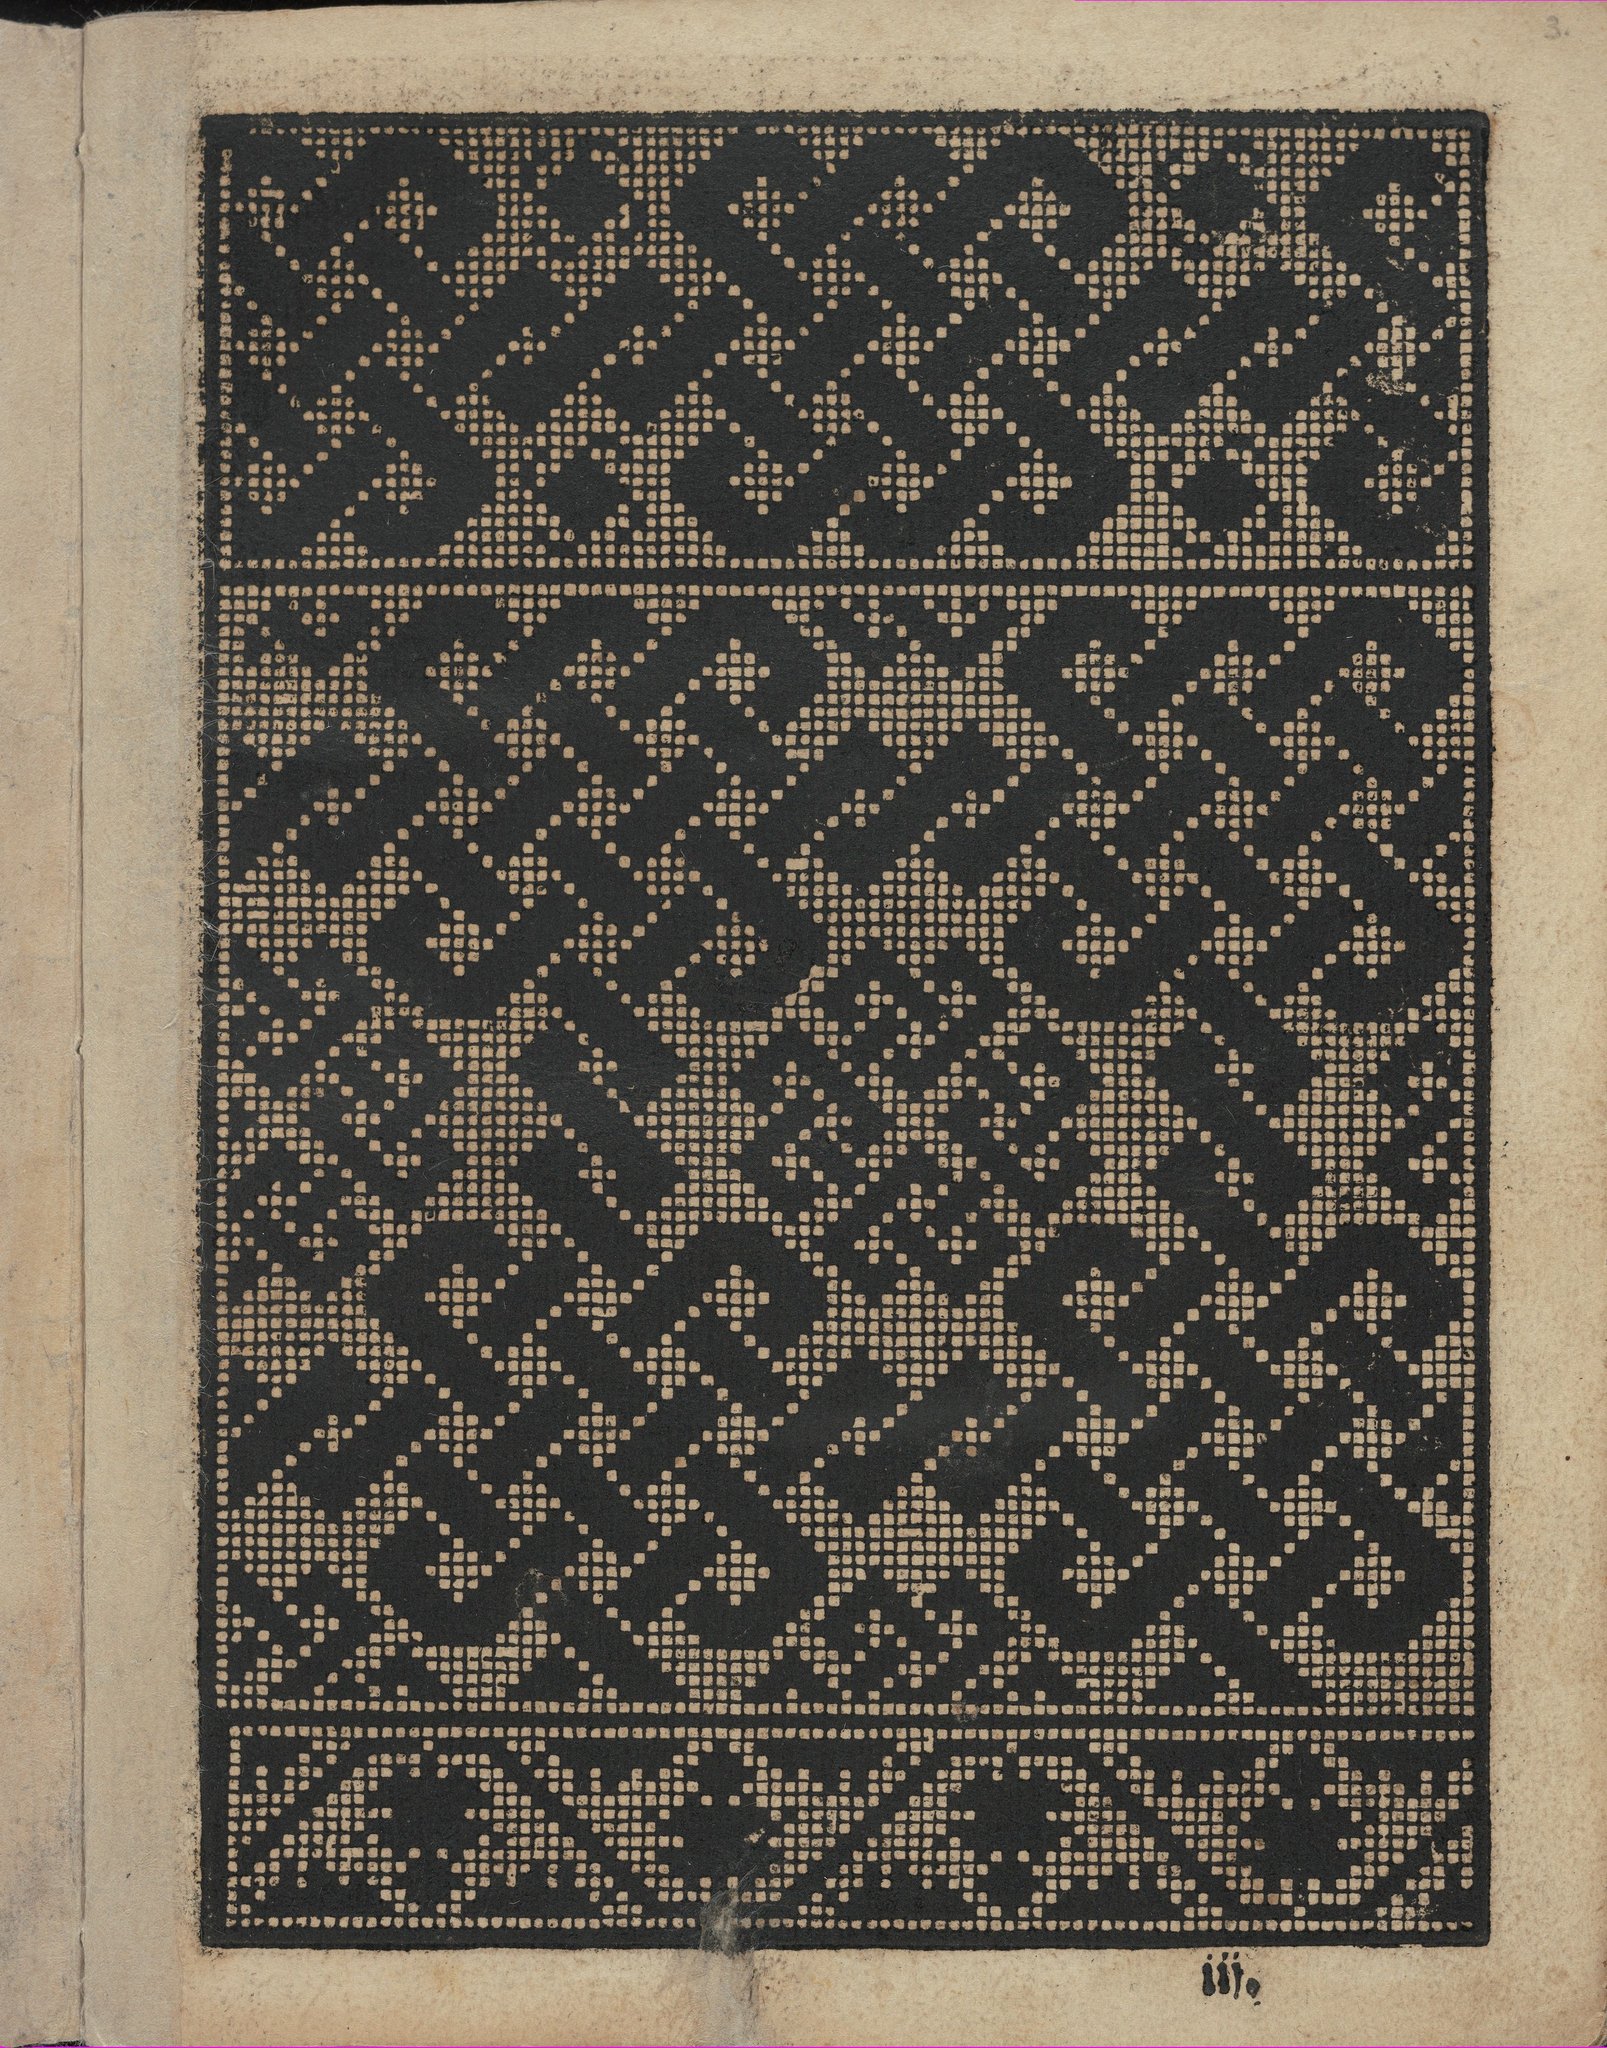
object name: book print ornament architecture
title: Libbretto nouellamete composto per maestro Domenico da Sera...lauorare di ogni sorte di punti, page 3 (recto)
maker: domenico da sera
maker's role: publisher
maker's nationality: french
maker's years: 1500-1599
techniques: woodcut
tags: ornament